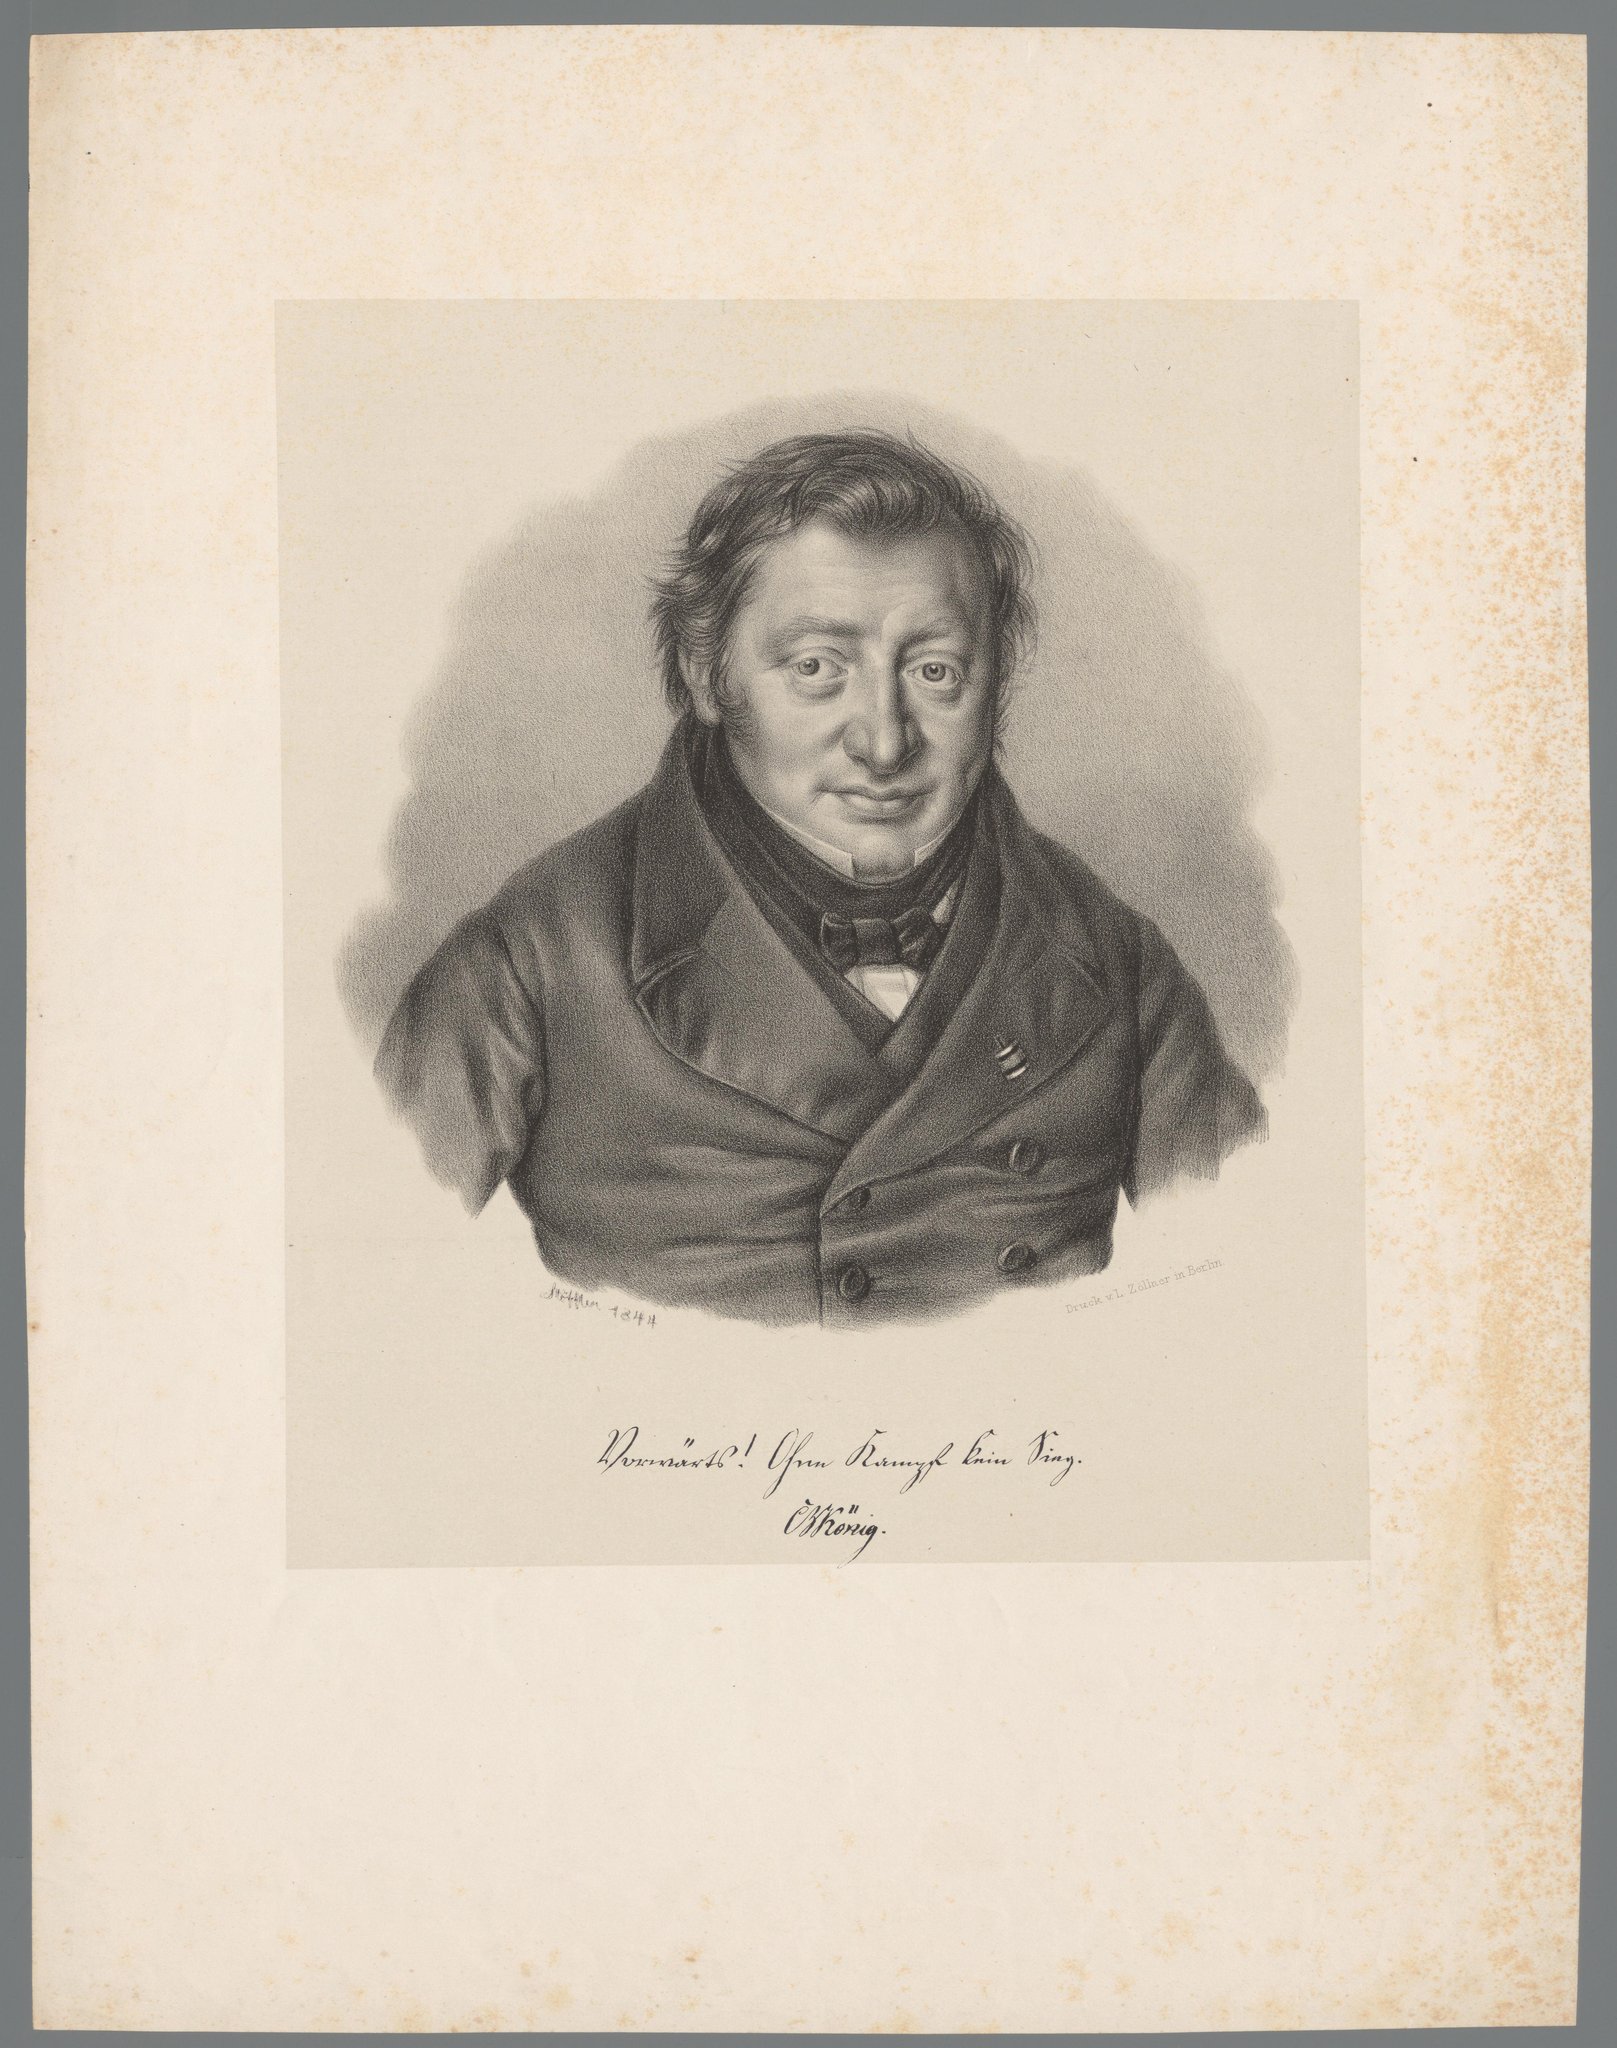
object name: print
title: Portret van C.Z. König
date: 1844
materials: paper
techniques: lithograph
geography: berlin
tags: historical persons not known by name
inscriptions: collector's mark: Lugt 2228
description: Portret van een verder onbekende man, met handtekening in facsimile waarin de naam C.Z. König te lezen is.